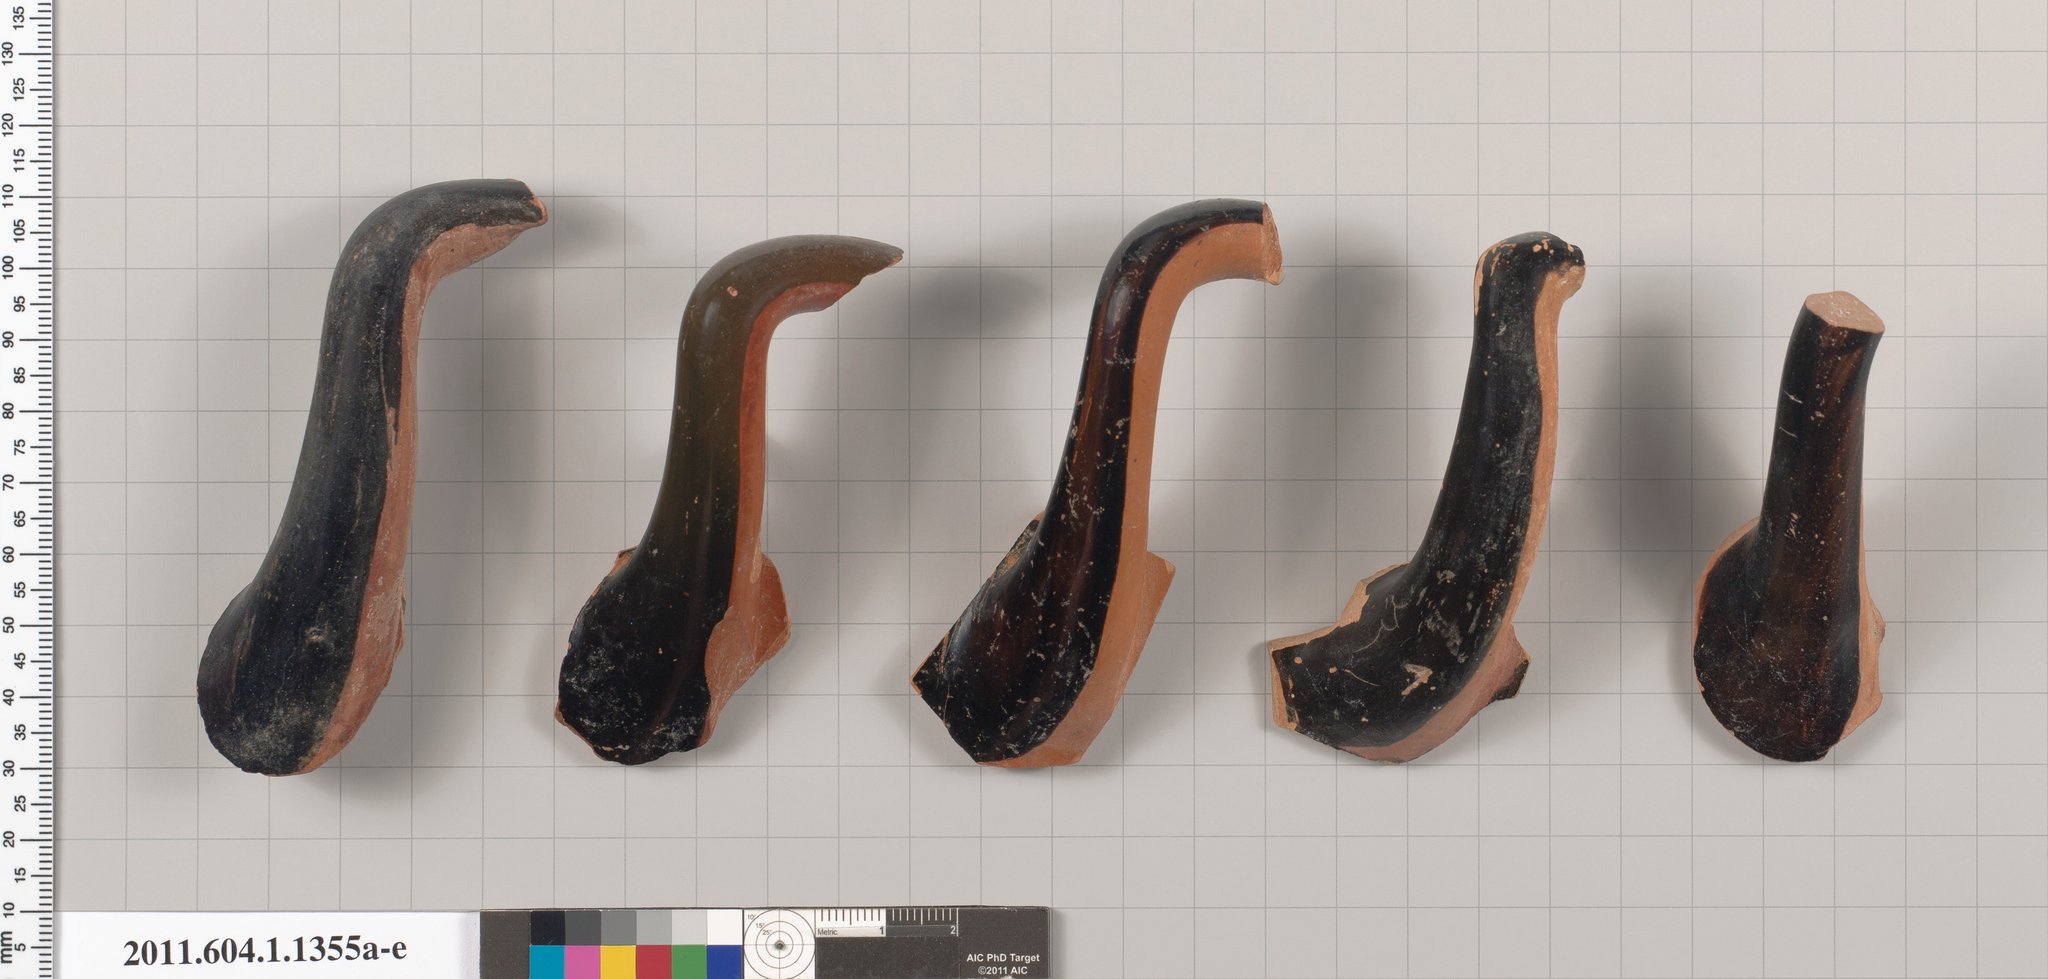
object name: kylix fragment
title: Terracotta fragments of kylikes (drinking cups)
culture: greek, attic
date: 500-401 BCE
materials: terracotta